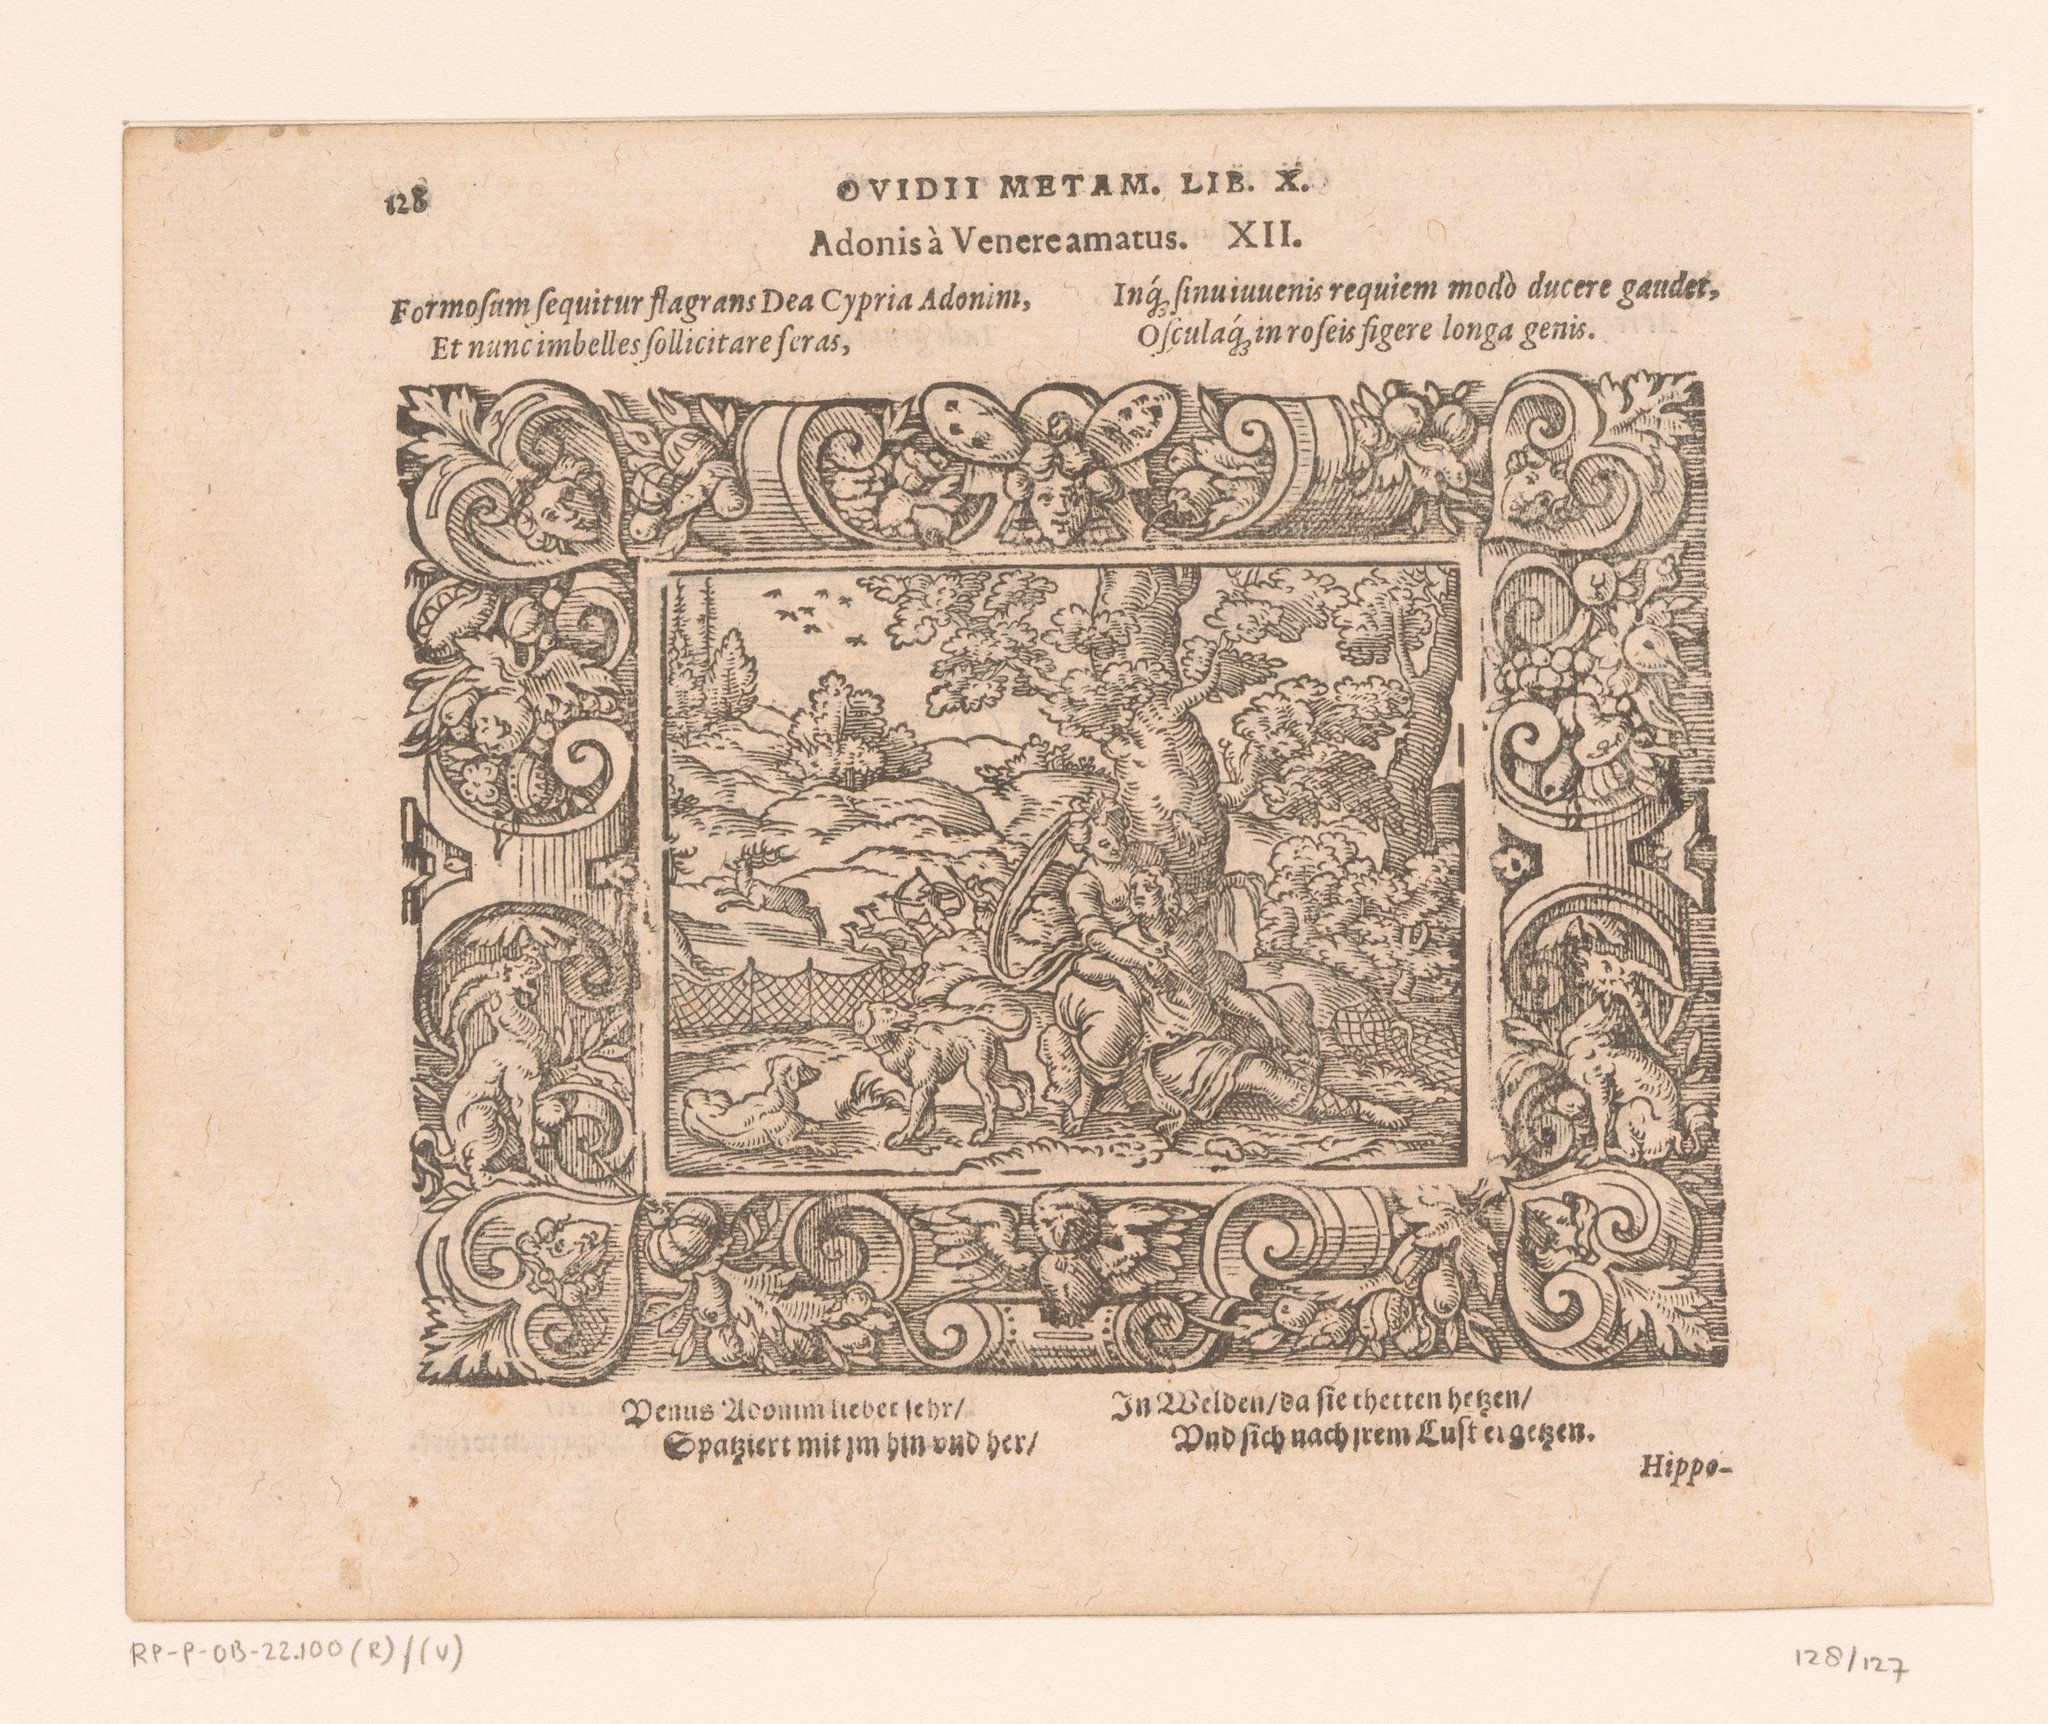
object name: print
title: Adonis à Venere amatus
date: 1569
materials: paper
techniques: letterpress printing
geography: nuremberg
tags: scrollwork, strapwork ~ ornament, venus trying to prevent adonis from going hunting, venus and adonis as lovers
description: Illustratie bij de Metamorfosen van Ovidius, afkomstig uit de publicatie: Posthius, Johannes. Tetrasticha in Ovidii metam. Frankfurt am Main: Georg Rab en Sigmund Feyerabend en erven Weigand Han, 1569. De voorstellingen en ornamentranden van deze boekillustraties zijn van twee aparte blokken gedrukt. Beide werden afzonderlijk van elkaar ook gebruikt voor andere publicaties, en de ornamentranden werden eveneens binnen deze publicatie meerdere keren gebruikt.